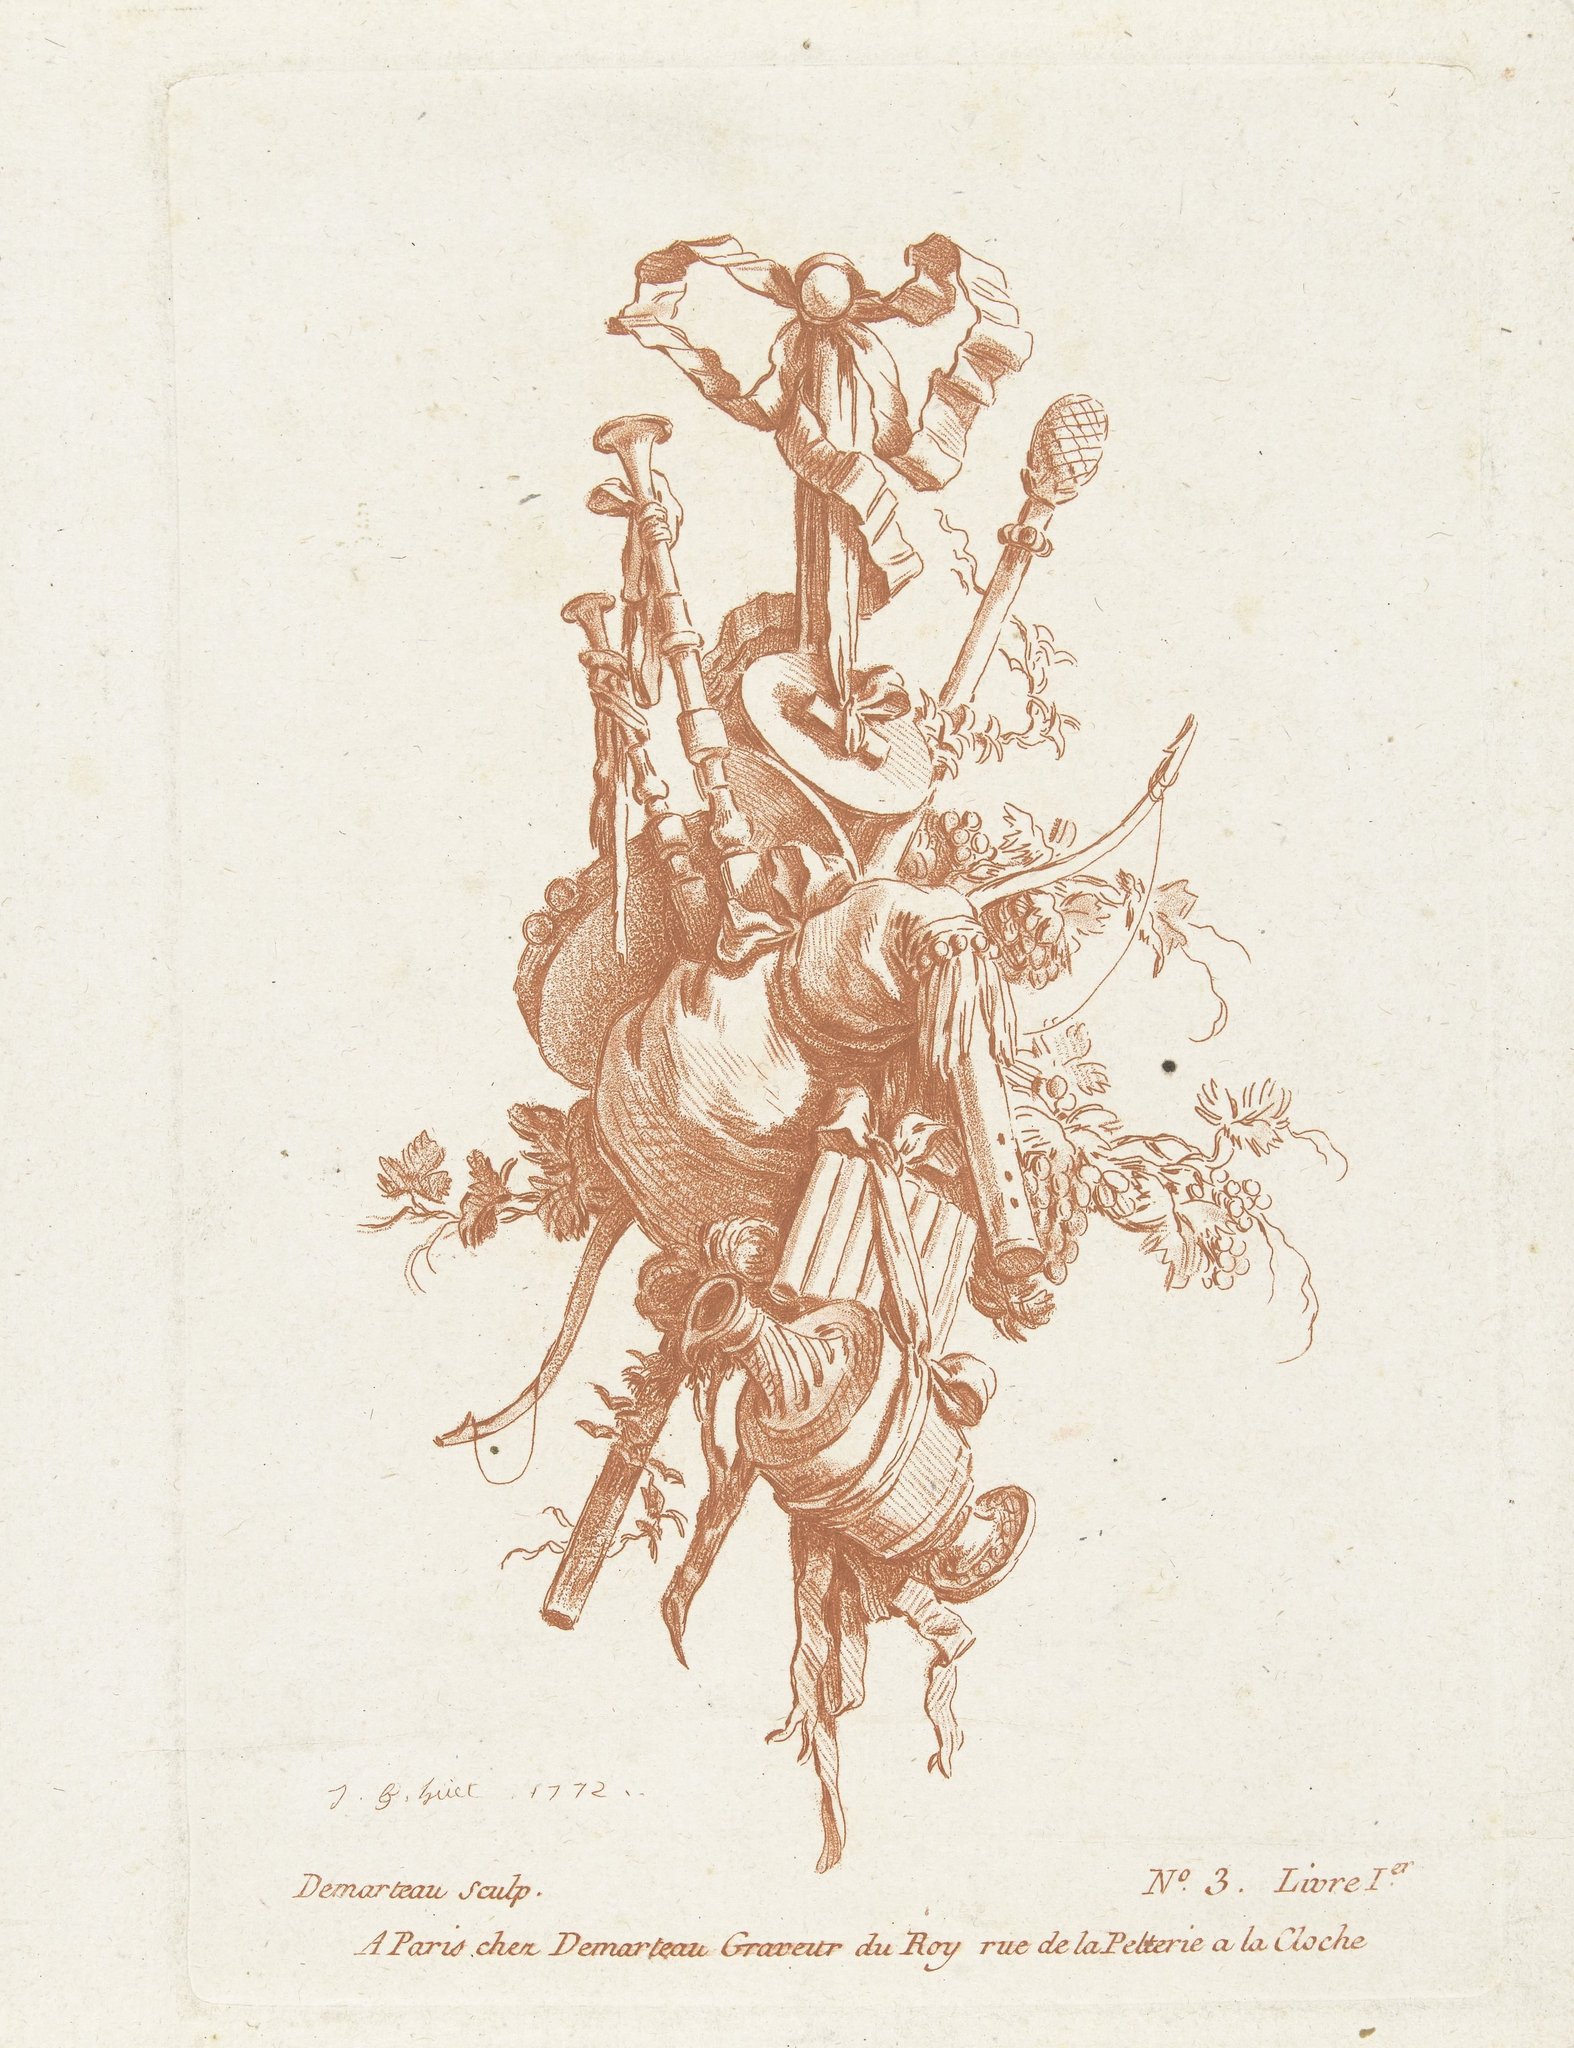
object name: book illustration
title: Trofee met muziekinstrumenten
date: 1772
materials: paper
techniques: printing, printmaking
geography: paris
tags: musical instruments; group of musical instruments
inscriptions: collector's mark: Lugt 2228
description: Prent gebruikt als boekillustratie in onbekende uitgave met meerdere delen, uit eerste deel, nr. 3, aldus opschrift.